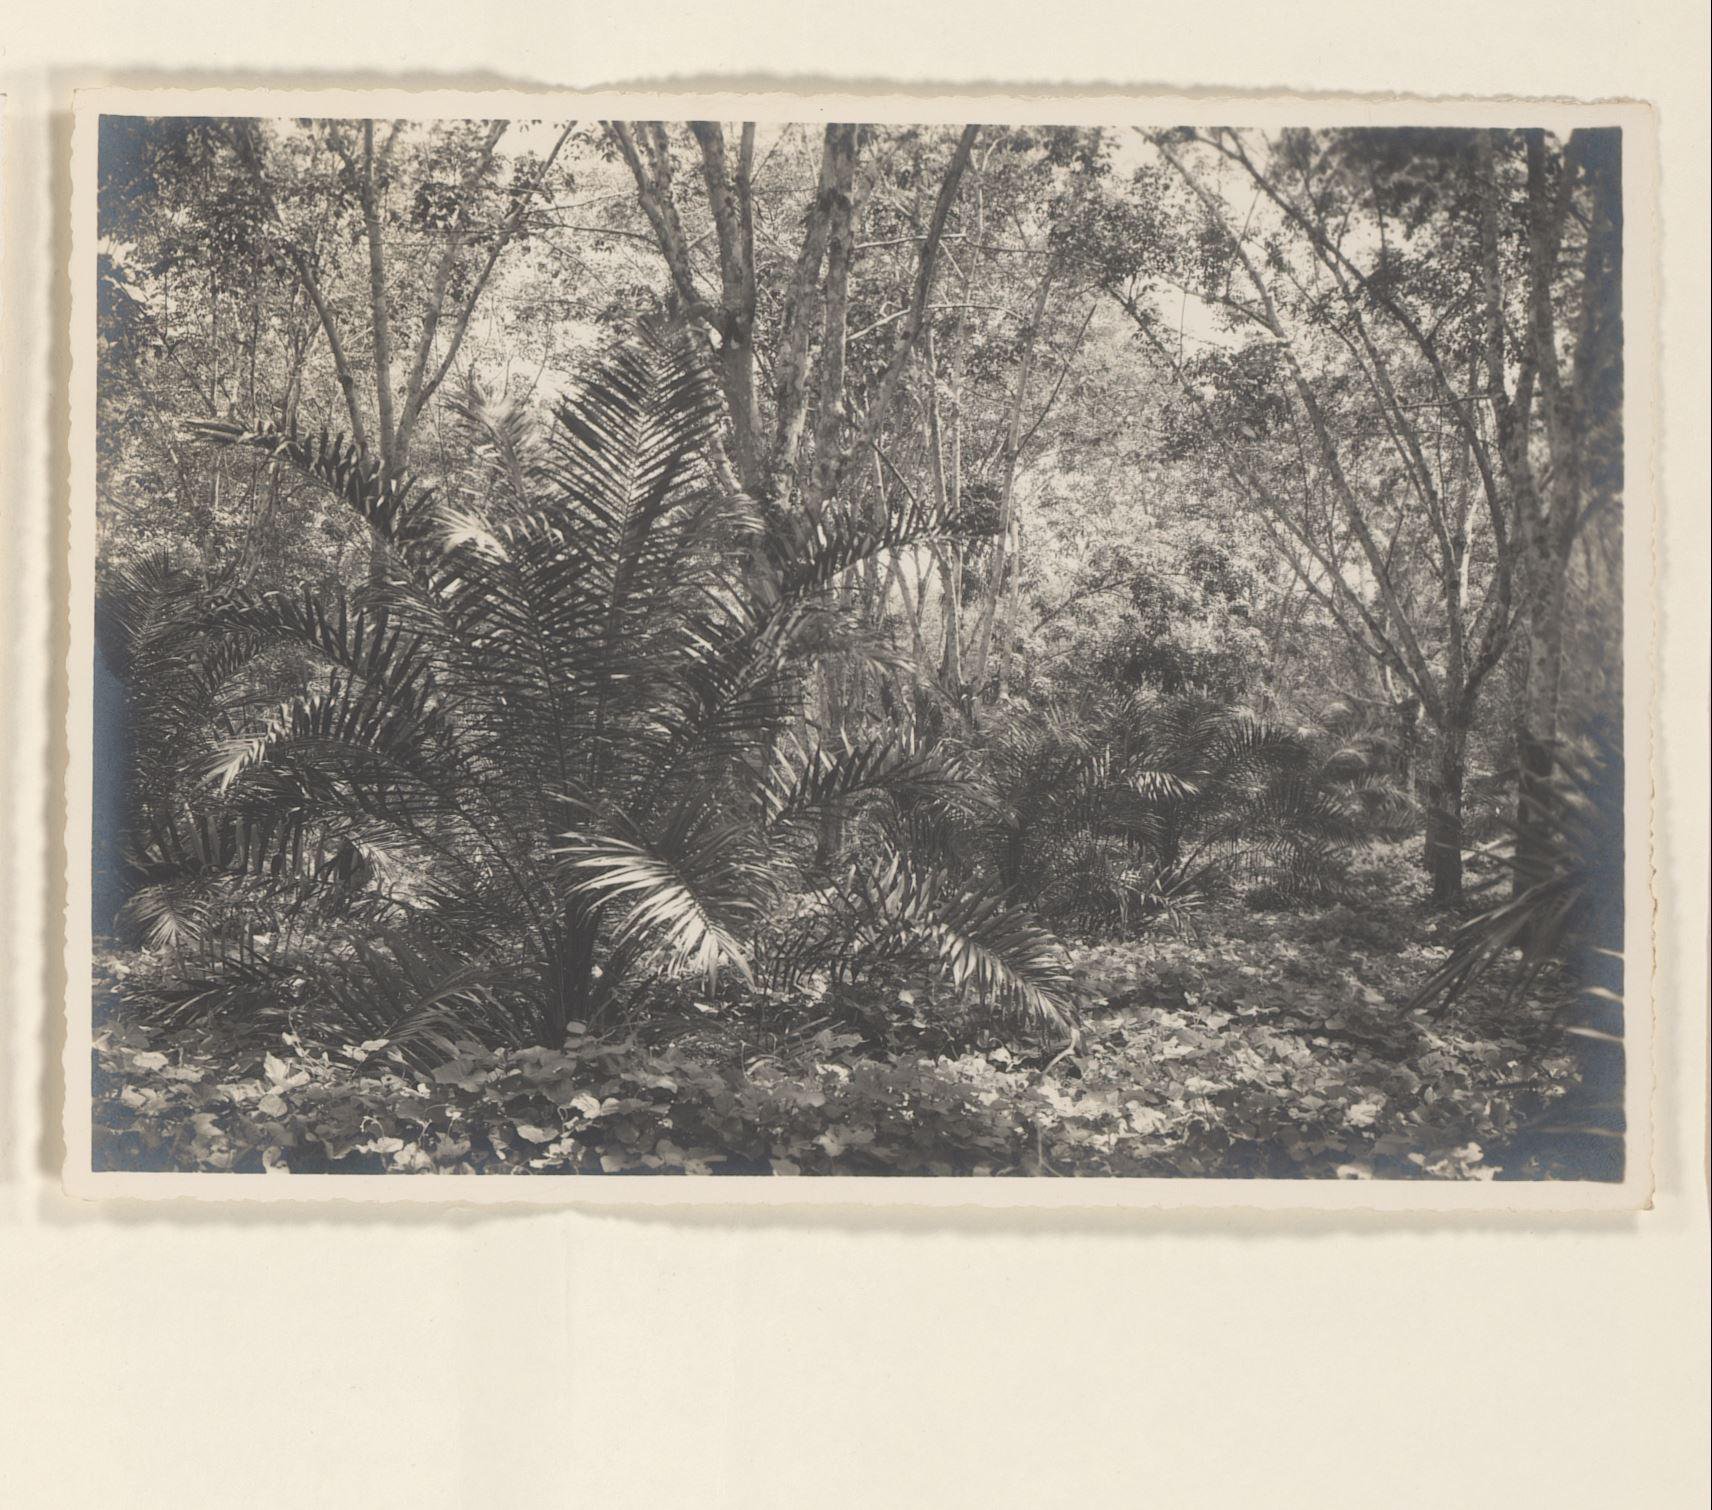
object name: photograph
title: Oliepalmen tussen rubberaanplant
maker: Anonymous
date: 1906-1938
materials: photographic support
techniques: gelatin silver print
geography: sumatra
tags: plantation, (non-fruit) products of plants or trees: rubber, (non-fruit) products of plants or trees: palm oil, sumatra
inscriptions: date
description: Oliepalmen tussen rubberbomen op de plantage Brussel, juni 1938. Tweede afdruk, los in melinexhoesje, van een foto ingeplakt op albumblad 8. Onderdeel van het fotoalbum over de plantages Pernantian en Brussel van de Sumatra Caoutchouc Maatschappij op de Oostkust van Sumatra in de jaren 1935-1939.